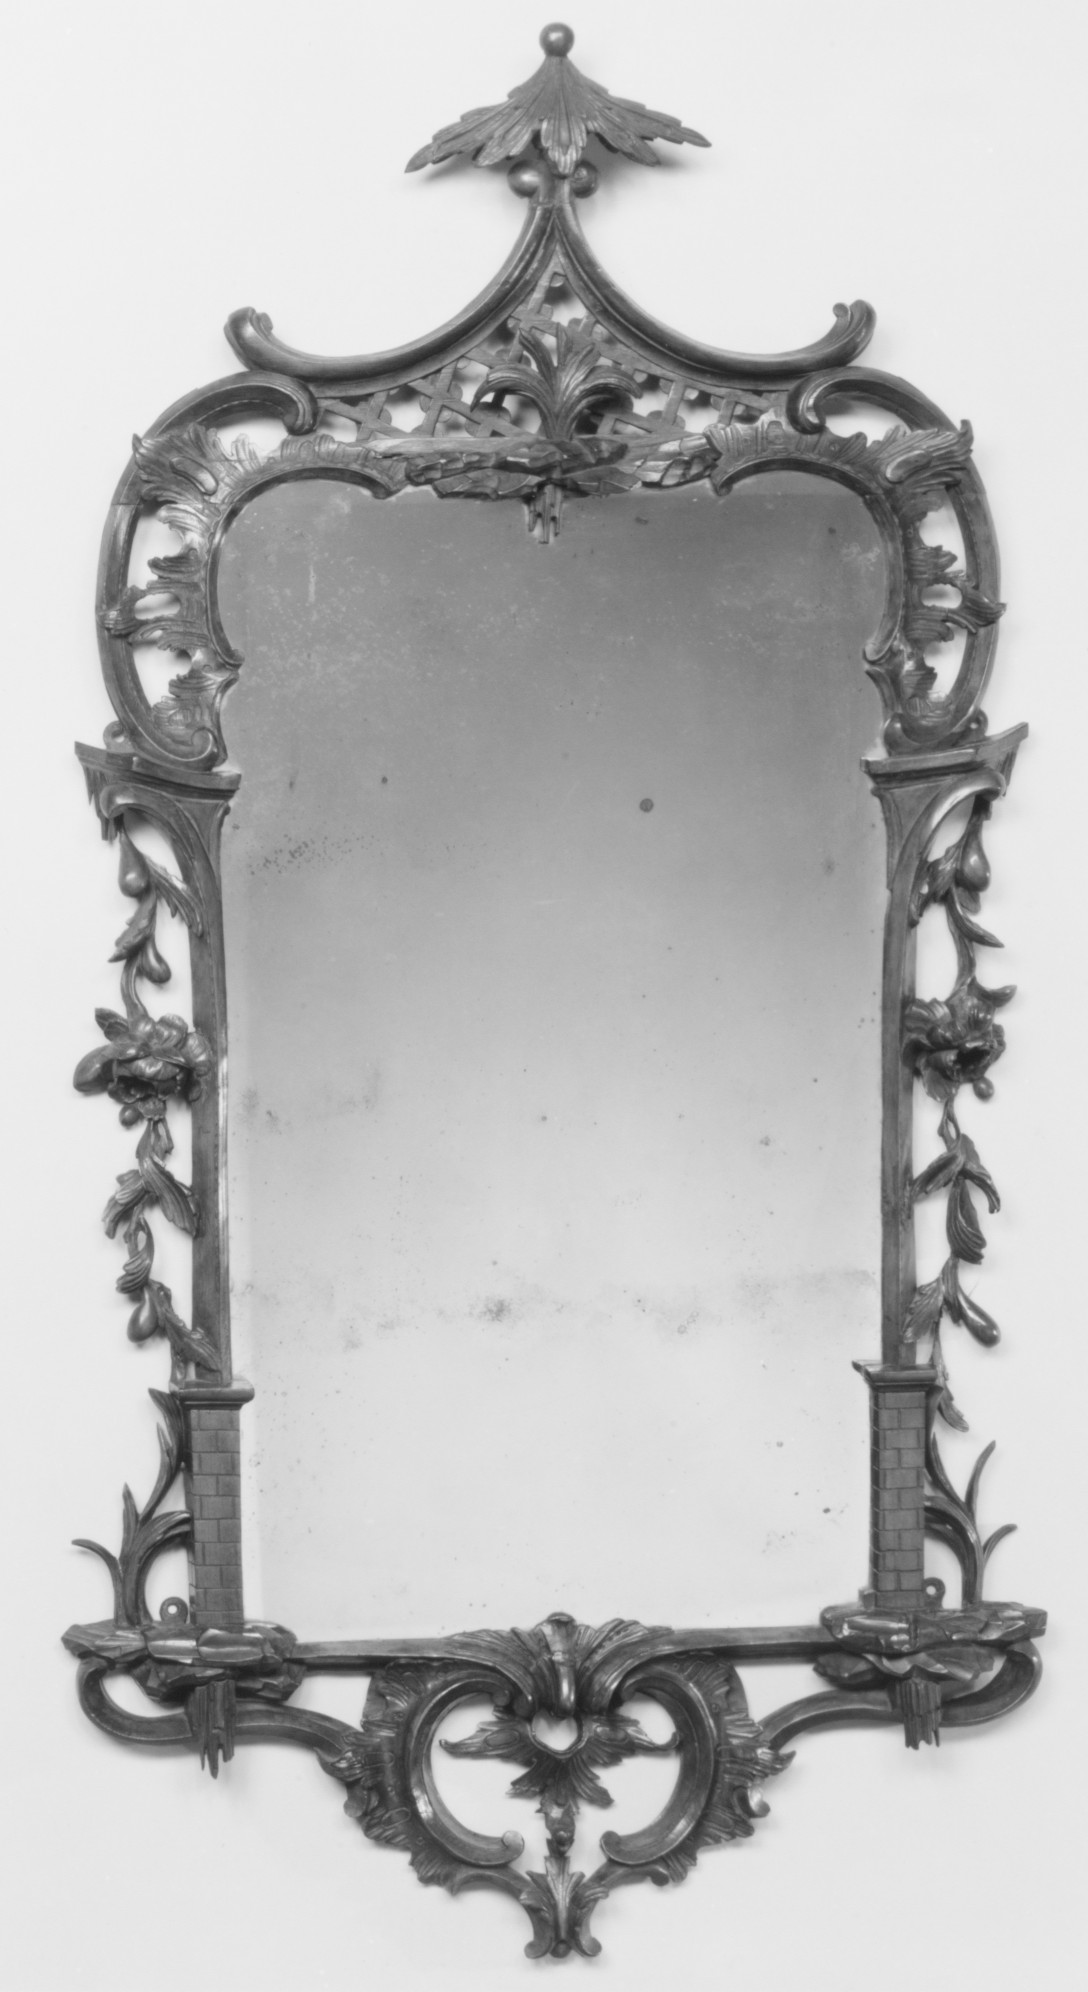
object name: mirror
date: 1765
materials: wood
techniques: stain